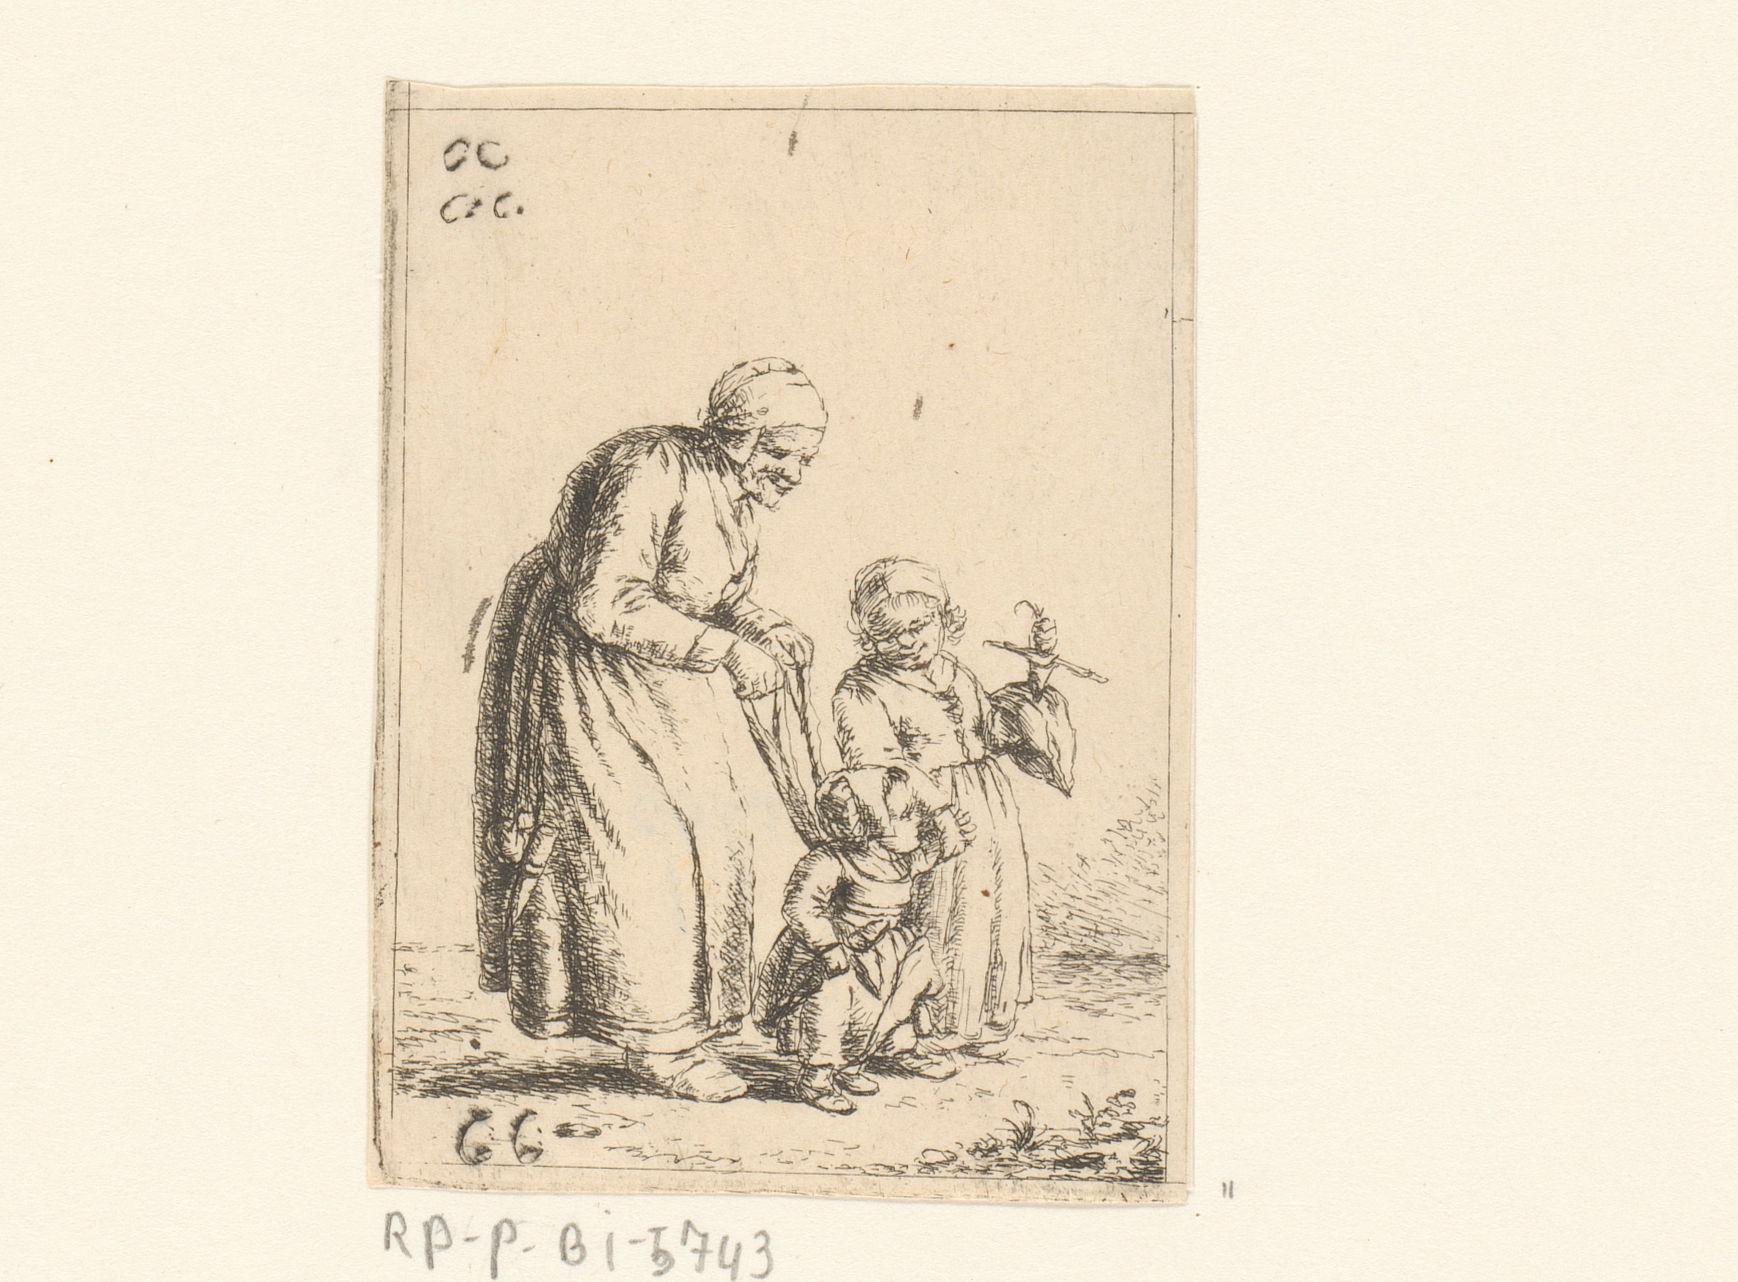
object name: print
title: Moeder leert kind lopen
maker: christina chalon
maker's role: draughtsman, print maker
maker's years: 1748-1808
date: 1758-1808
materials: paper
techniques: etching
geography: leiden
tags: (playing with) dolls, implements for learning to walk, go-cart, mother and child(ren), woman and child(ren) (family group) (with number of children), learning to walk, the first steps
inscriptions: collector's mark: Lugt 240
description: Een moeder leert een kind lopen door middel van een tuigje en een leiband. Het kind haar zusje helpt haar. beide kinderen hebben een pop vast.